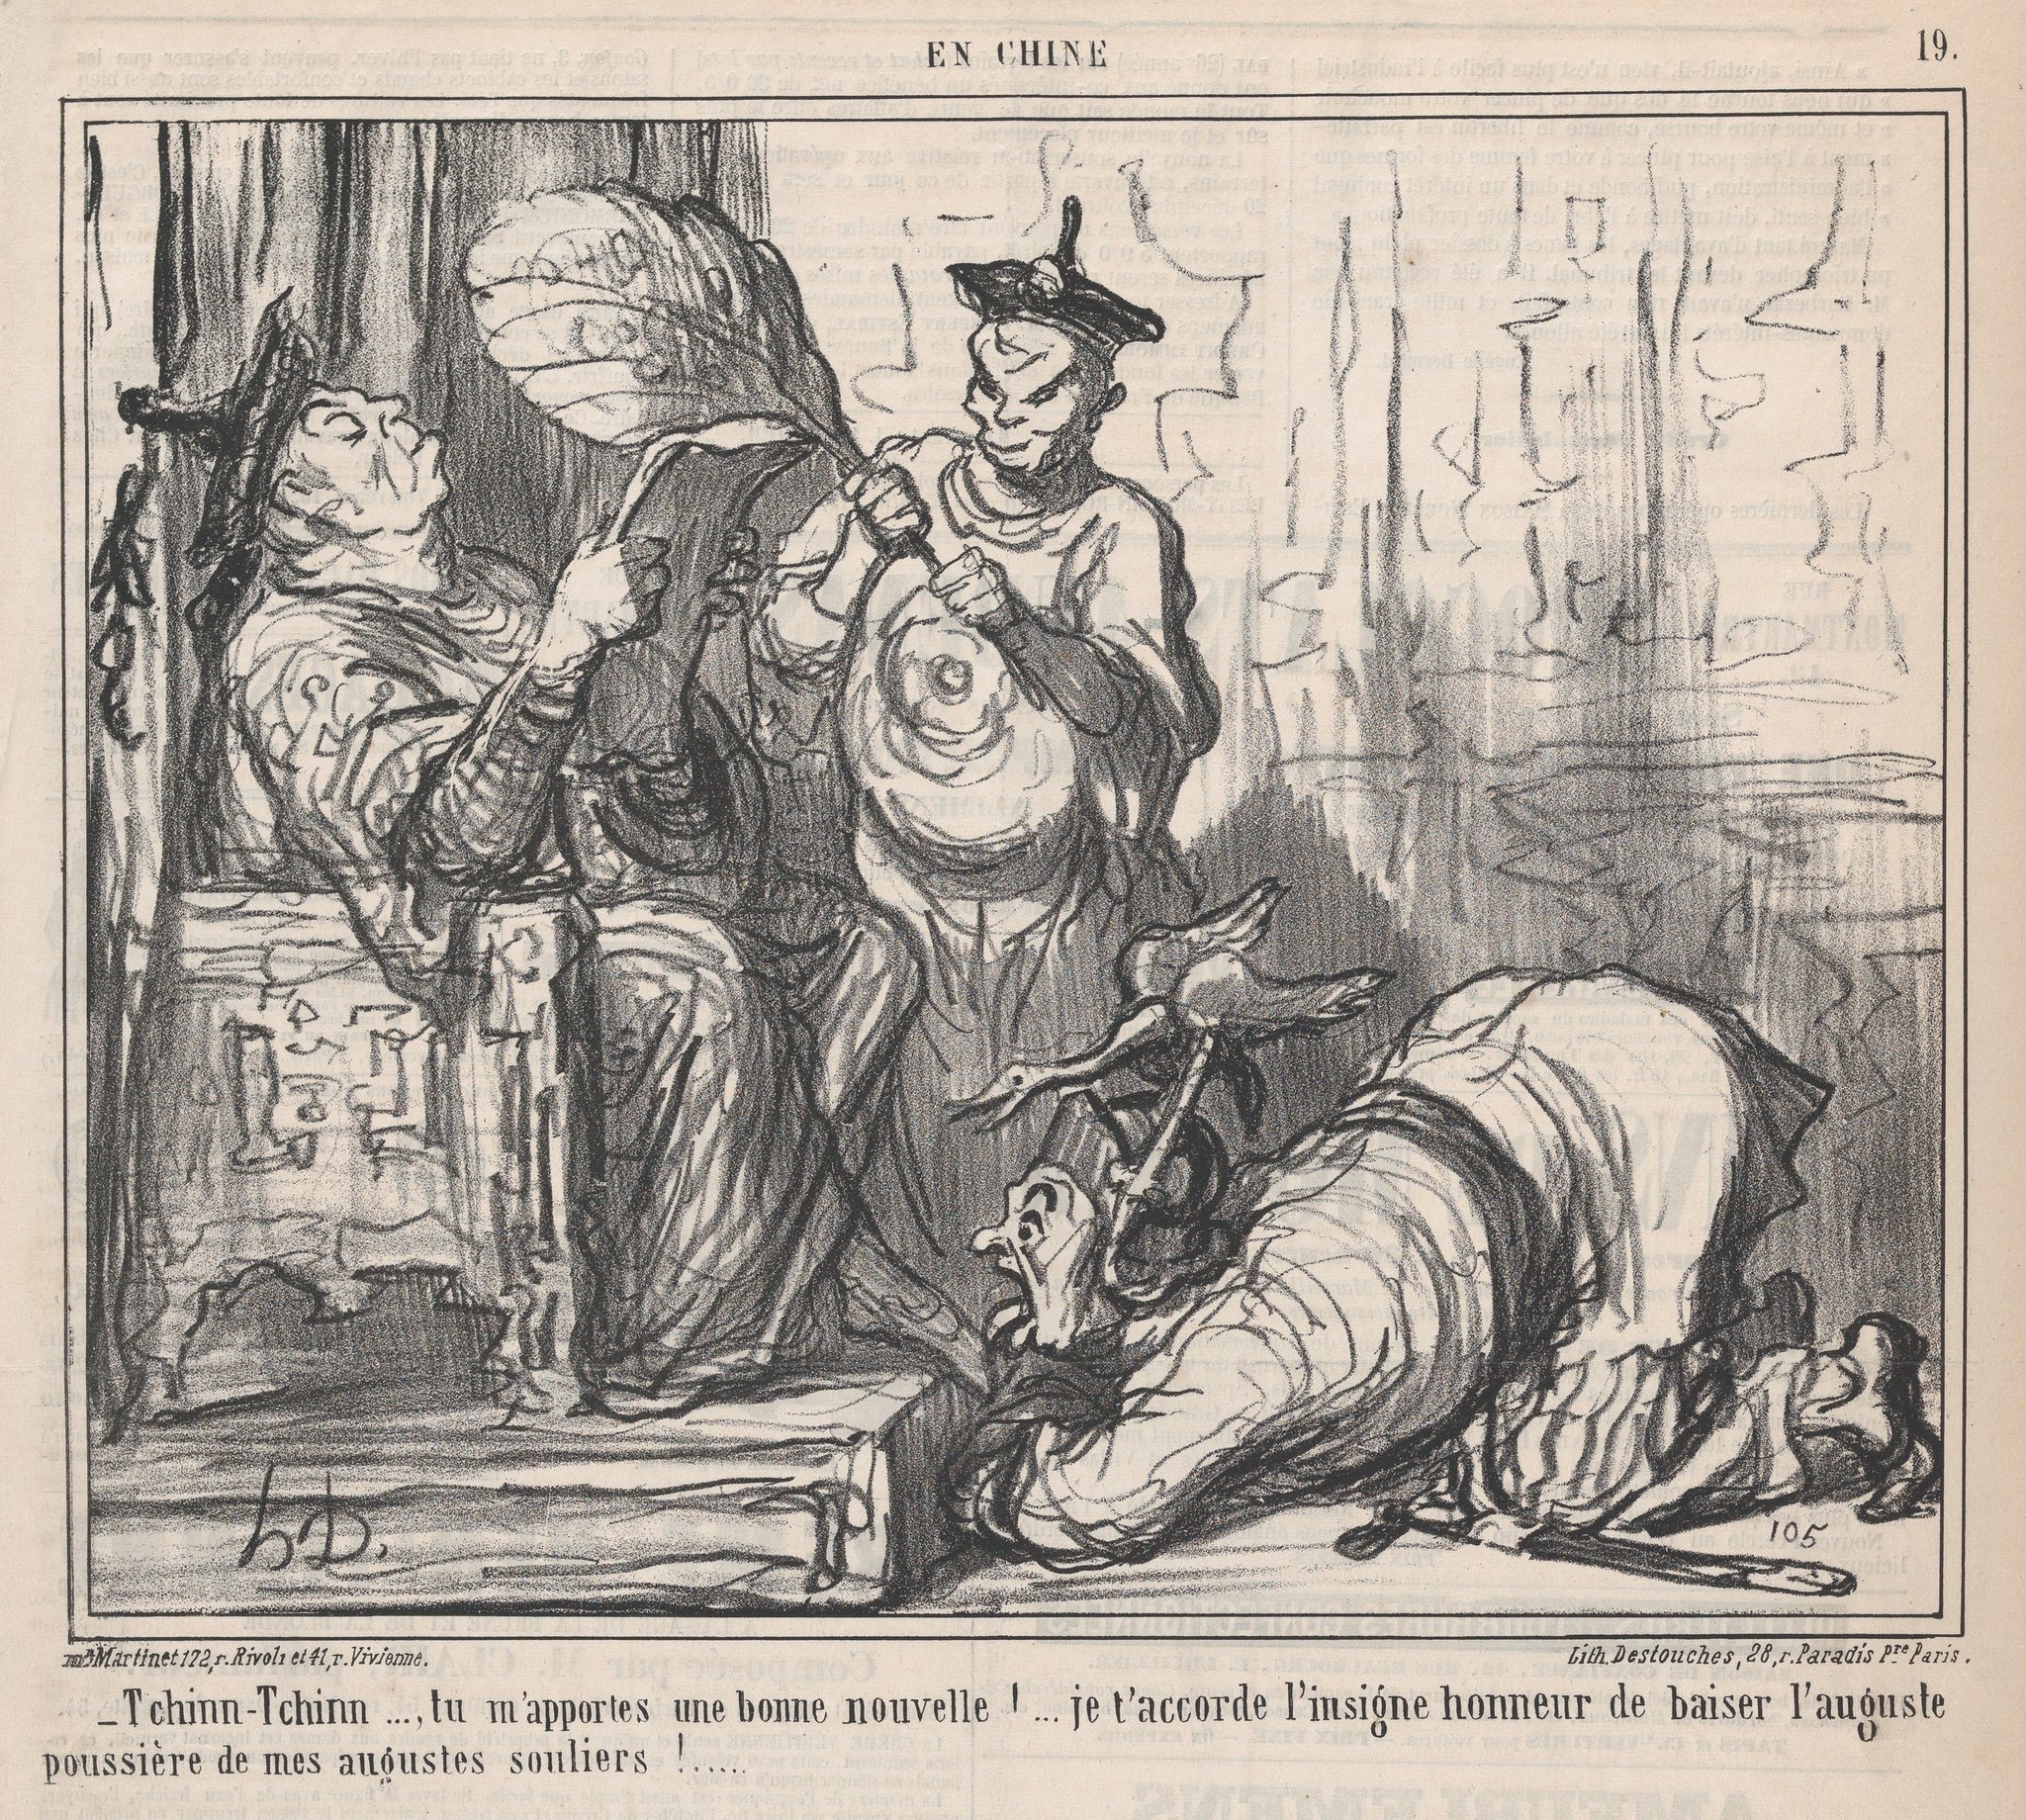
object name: print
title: Tchinn-Tchinn..., tu m'apportes une bonne nouvelle! .... je t'accorde l'insigne honeur de honneur de baiser l'auguste poussière de mes augustes souliers!...., from En Chine, published in Le Charivari, December 7, 1859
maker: honoré daumier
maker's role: artist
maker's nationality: french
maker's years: 1808-1879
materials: paper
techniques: lithograph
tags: birds,men